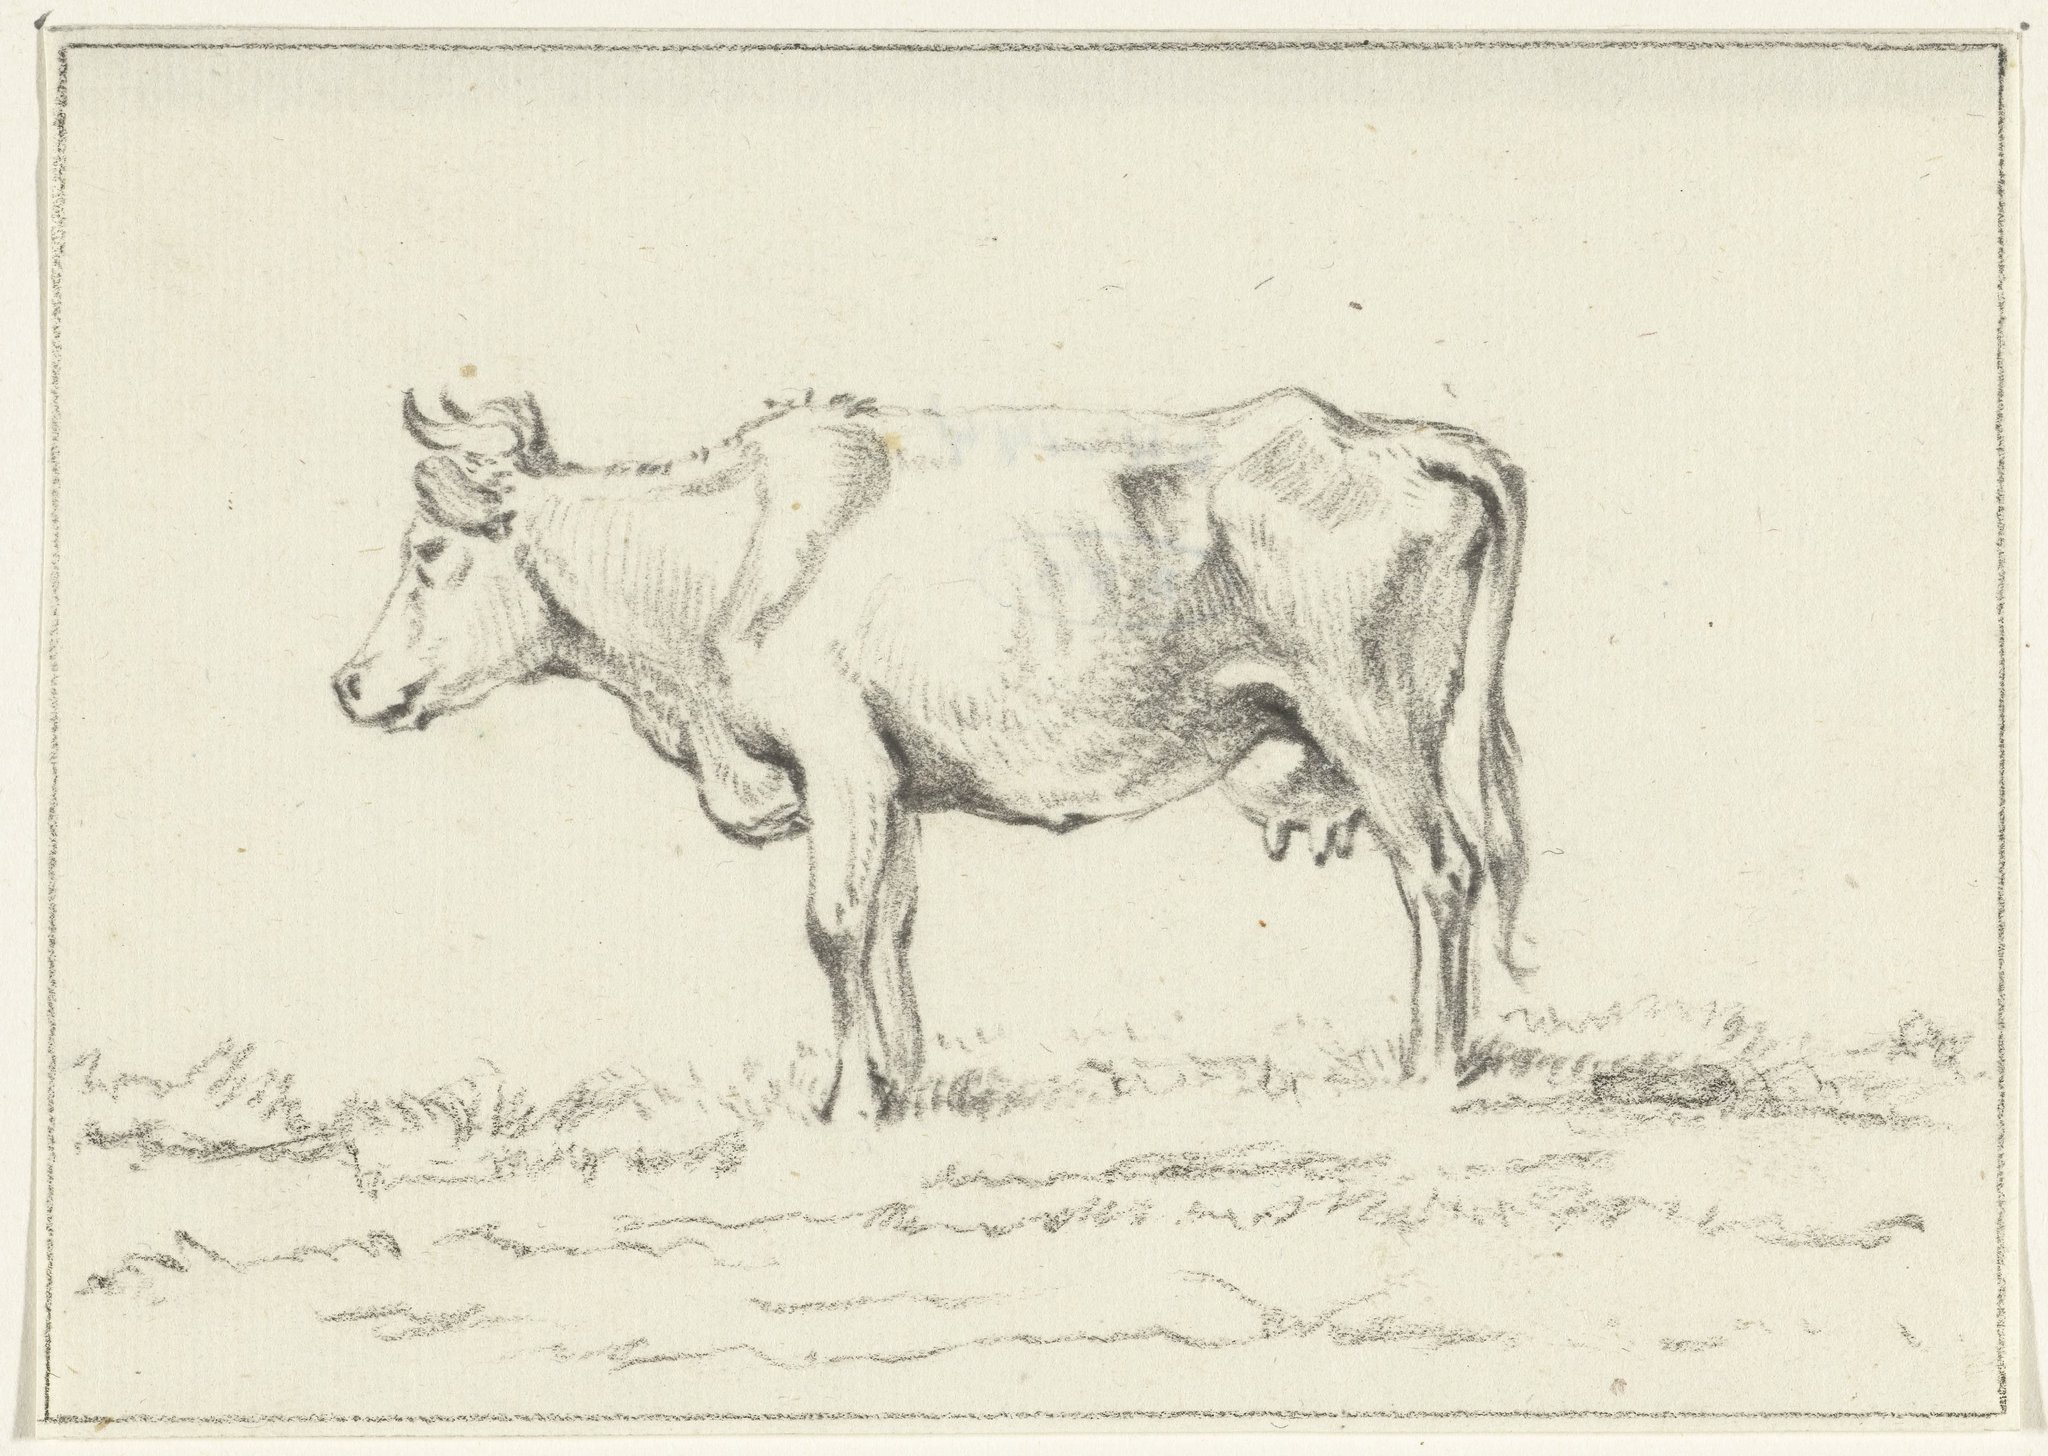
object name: drawing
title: Staande koe, naar links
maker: jean bernard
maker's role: draughtsman, print maker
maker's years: 1765-1833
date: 1775-1833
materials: chalk, paper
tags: cow